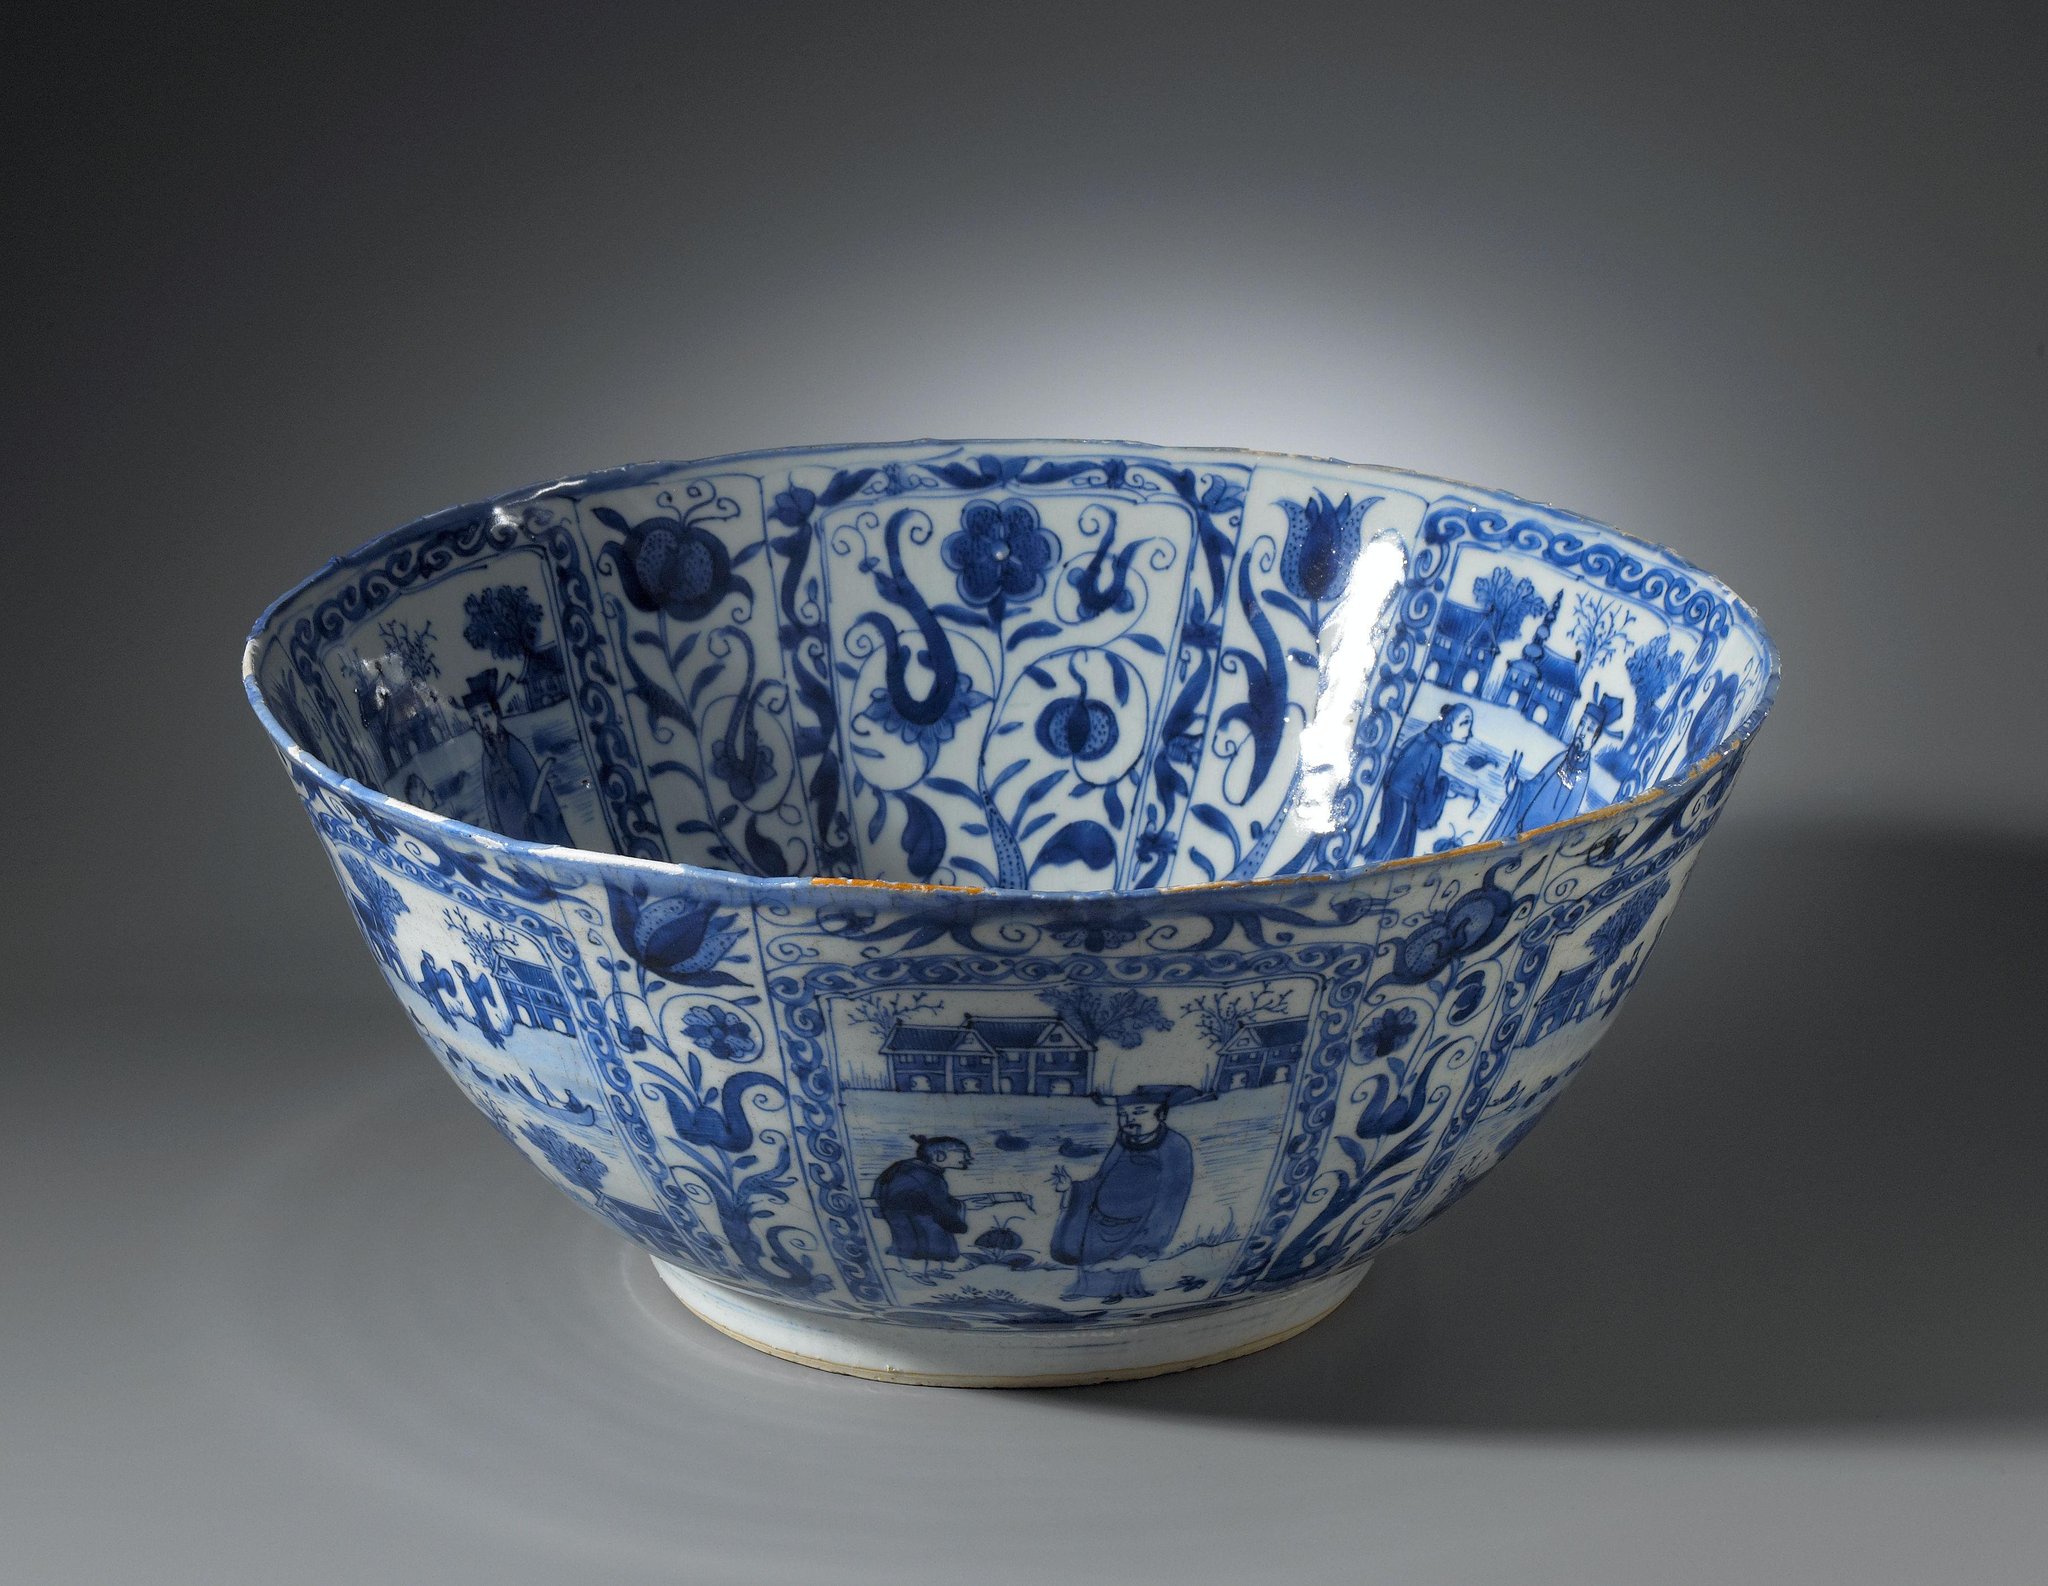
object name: bowl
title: Bowl with a woman with a reel, flowering plants and figures in landscapes in a panel decoration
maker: Anonymous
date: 1635-1650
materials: cobalt, glaze, paint, porcelain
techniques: firing, turning, vitrification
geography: china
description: Two bowls. Porcelain. China, 1st half 17th century.